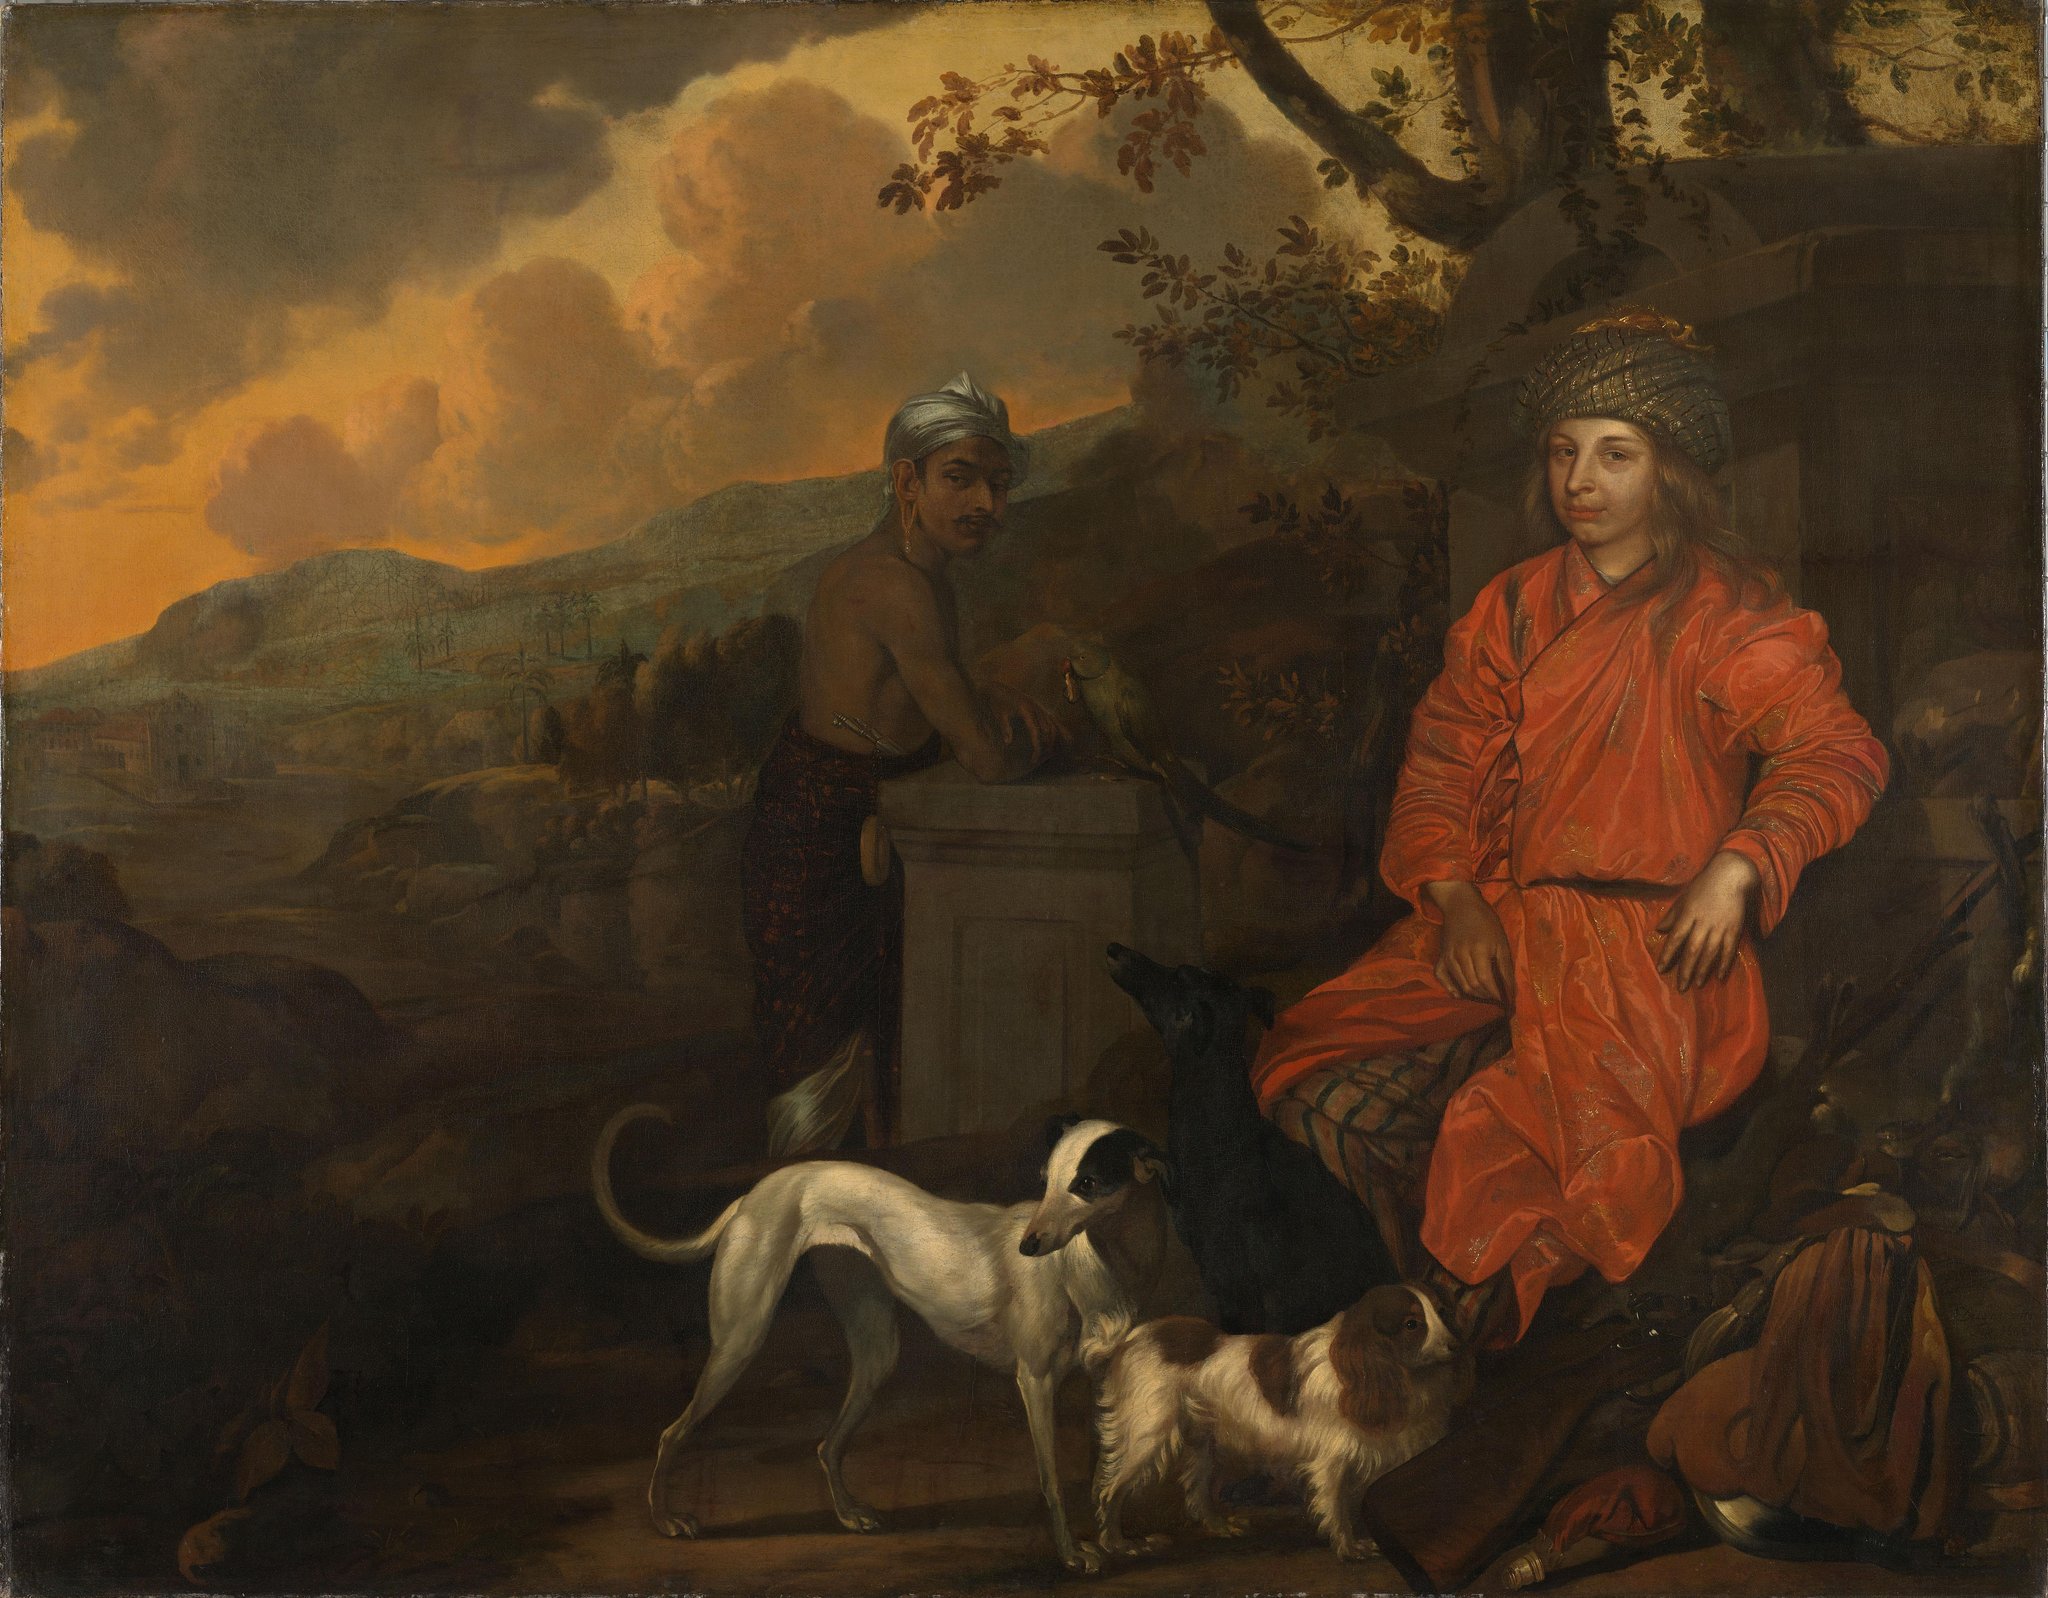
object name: painting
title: Philippus Baldaeus and his assistant Gerrit Mosopatam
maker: johan de la rocquette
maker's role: painter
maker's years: 1640-1694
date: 1668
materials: canvas, oil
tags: delft, geervliet, philippus baldaeus, landscapes, historical persons, dog, sri lanka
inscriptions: signature: ‘DeLarocquete Fcit 1668’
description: Philippus Baldaeus was active as a minister for the VOC on Ceylon (Sri Lanka) from 1654 to 1665. Back in the Netherlands, he had this picture painted to commemorate his years of service overseas. The seated Baldaeus wears clothing he brought with him from Asia. He is probably joined here by Gerrit Mossopotam, who resided with Baldaeus in the Netherlands and may have assisted him in translating Christian texts.